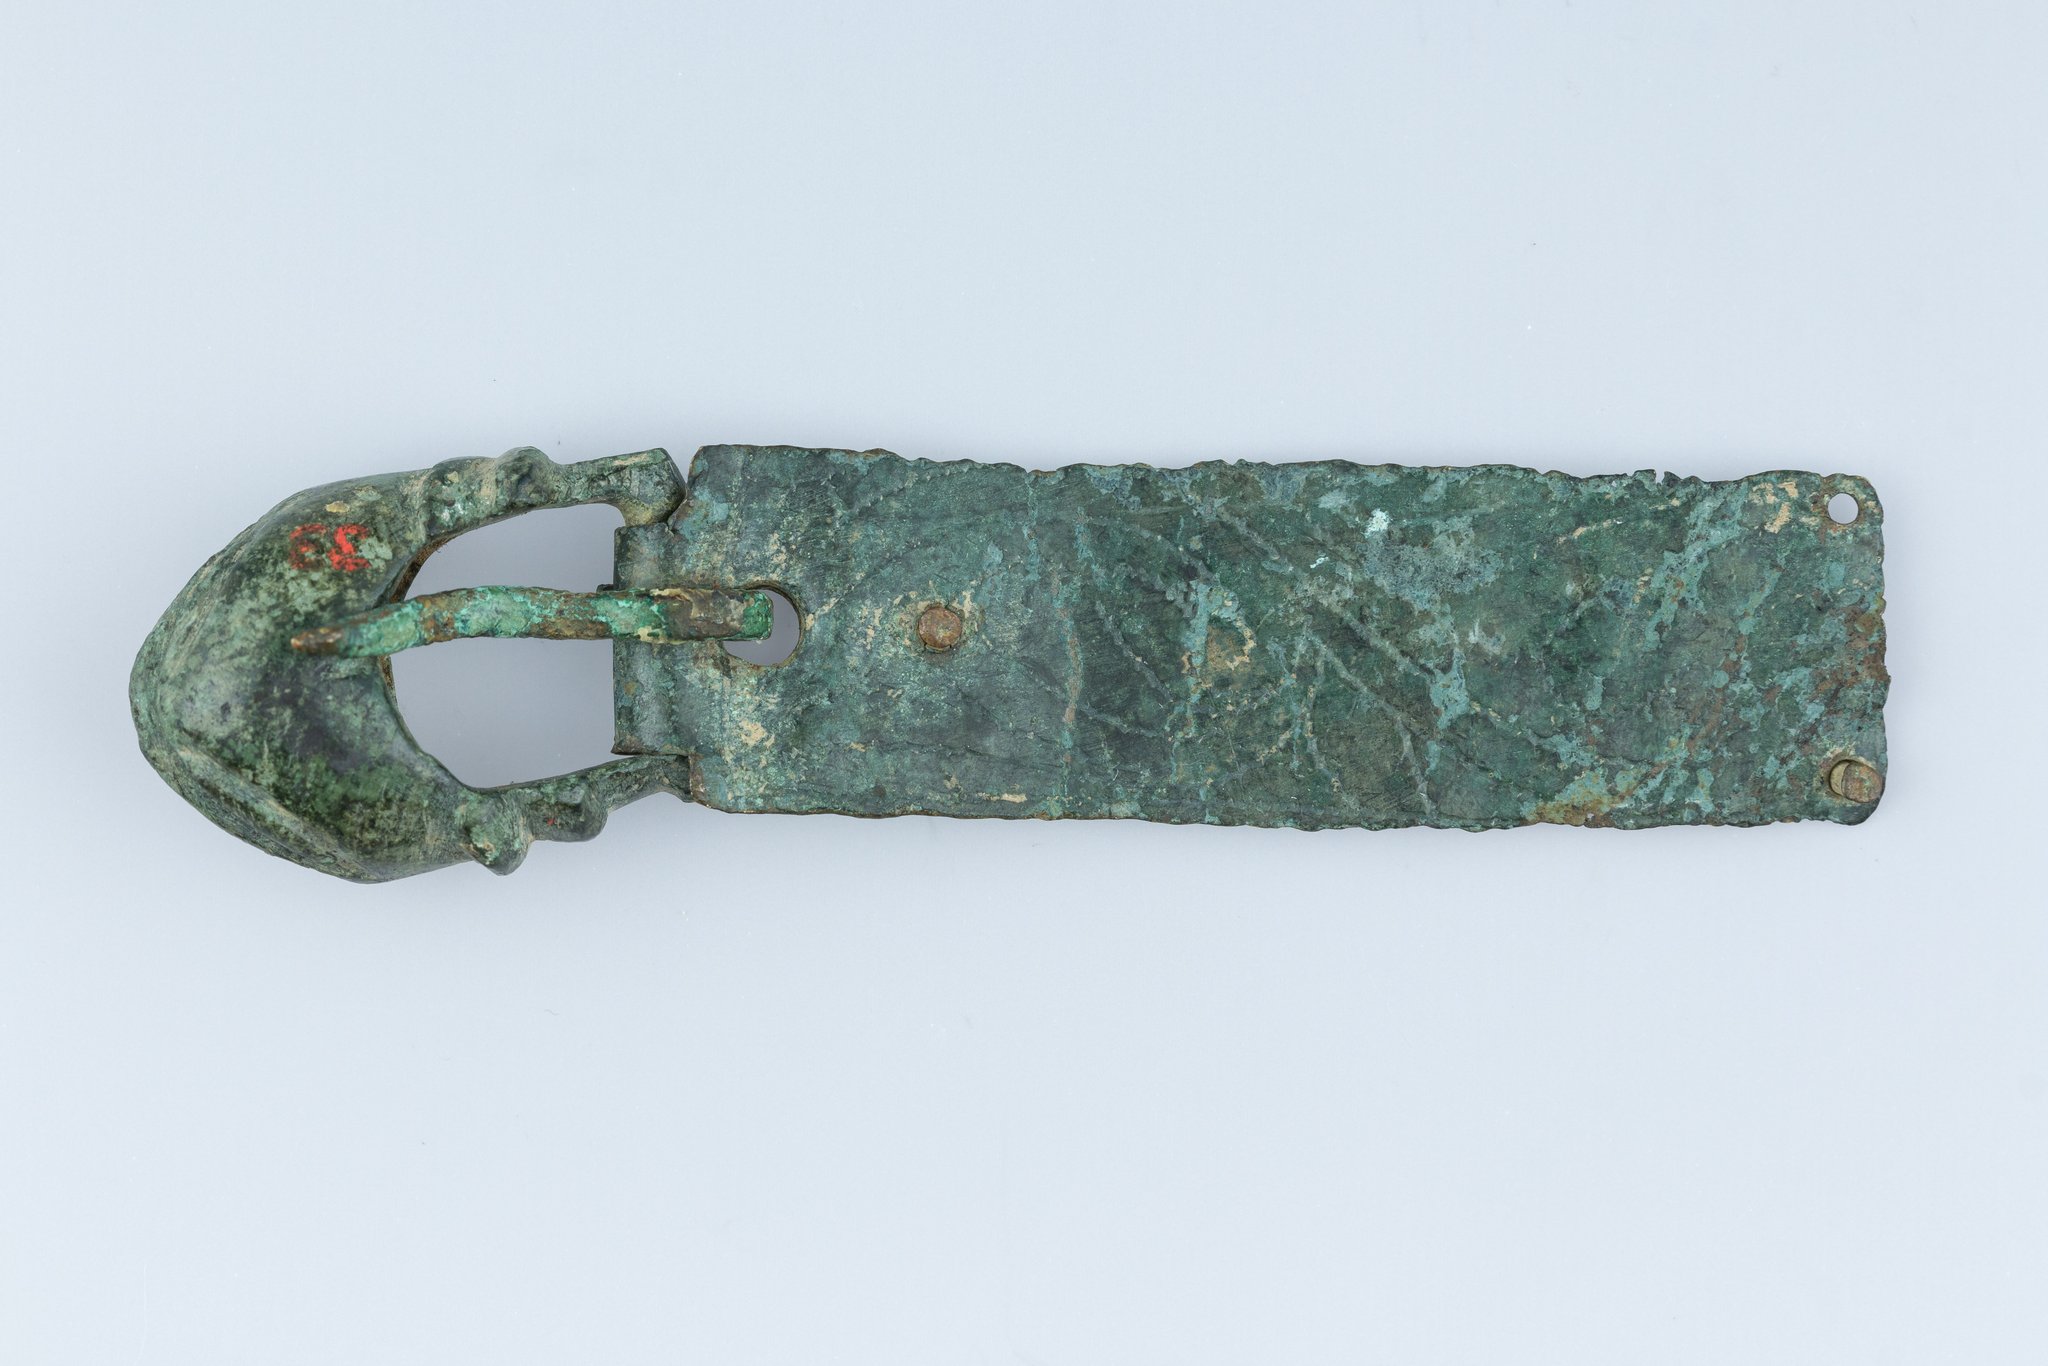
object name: buckle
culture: french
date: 1301-1400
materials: bronze, patina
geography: france